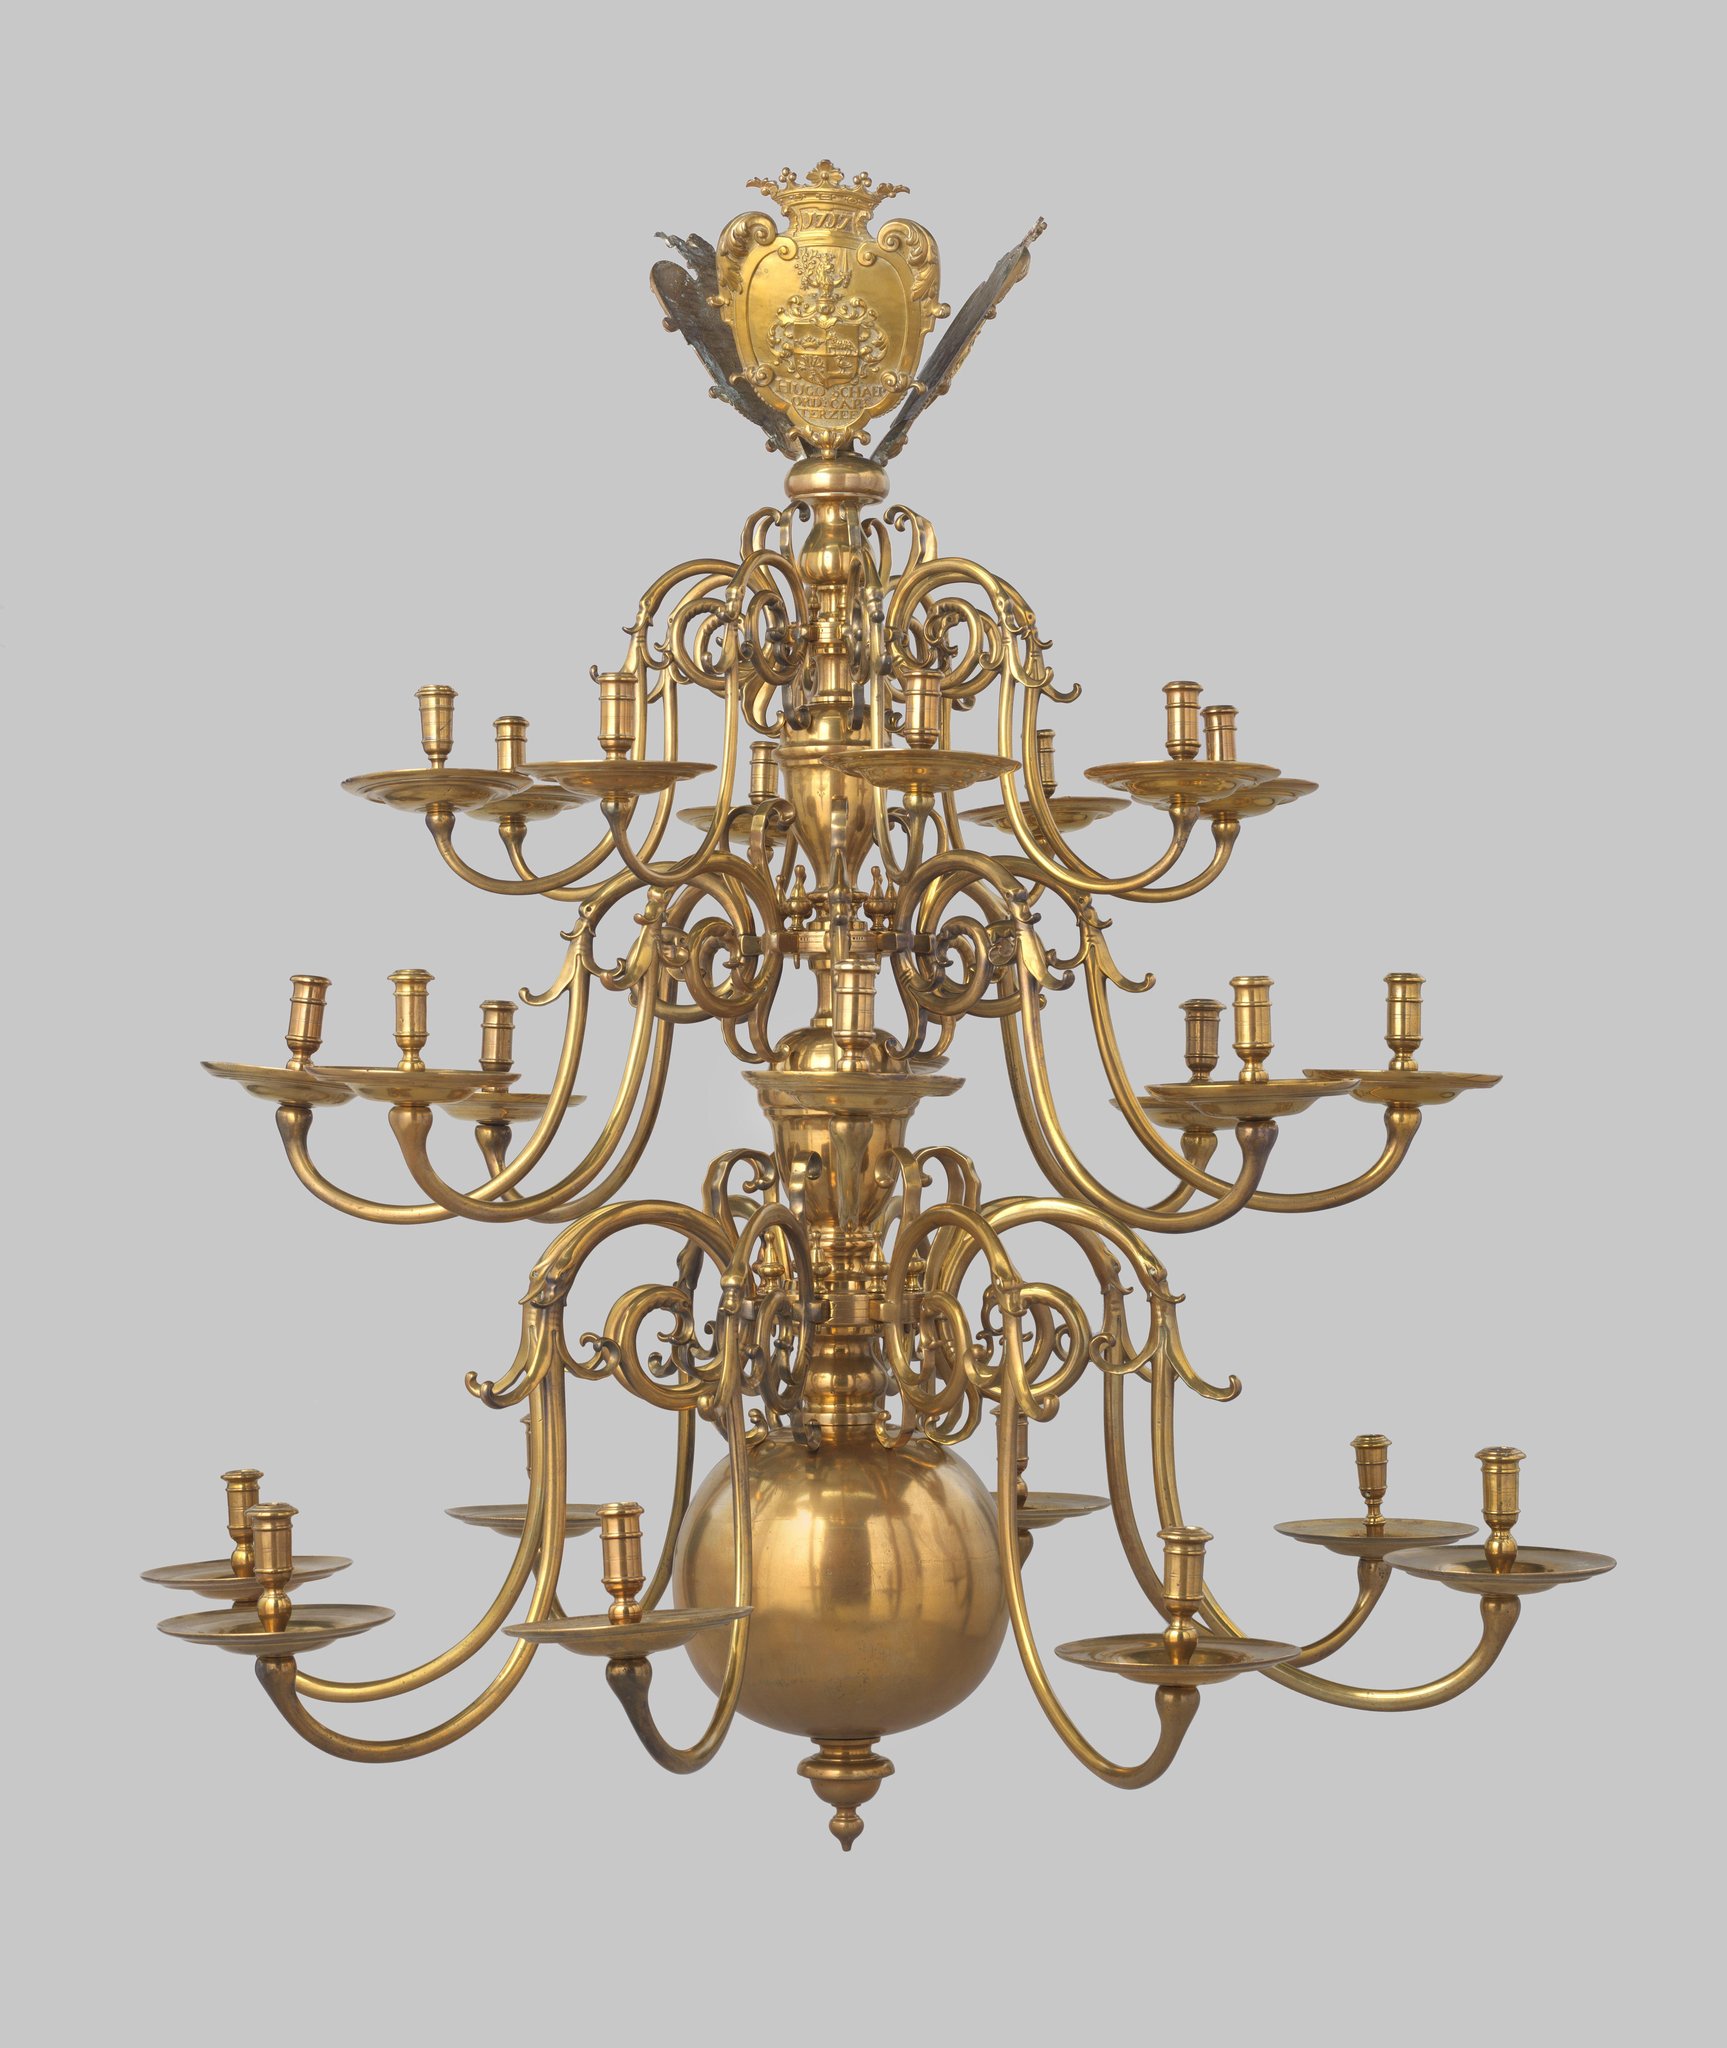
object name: chandelier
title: Arm van een kaarsenkroon in drie hoogten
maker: Anonymous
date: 1717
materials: brass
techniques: casting, screwed, turning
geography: amsterdam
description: De S-vormige arm is aan de stamzijde voorzien van een nok om deze met een pin in de standring te kunnen vastzetten. Bij de stam is de arm op het eind en naar het midden toe versierd met twee gestileerde dolfijnenkoppen en met krullen, waarvan de vorm aan het kwabornament is ontleend. Naar buiten toe eindigt de arm in een verdikking, waarin een van een schroefdraad voorzien gat is aangebracht ter bevestiging van de kaarsenhouder op de vetvanger. De arm is met behulp van hetzelfde model gegoten als de overige armen van de krans. De kaarsenhouder is cylindervormig met geprofileerd uitstekende rand en met een balustervoet, welke overgaat in een van een schroefdraad voorzien eind, waarin onderaan het centergat. De vetvanger is aan de bovenkant naar het midden toe twee keer verdiept. Aan de onderkant is deze rond het gat in het enigszins bolvormige midden geprofileerd en is de rand geribd. De vetvanger met behulp van hetzelfde model gegoten als de overige vetvangers van deze krans. De pin is voorzien van een vaasvormige knop. Dit is de achtste arm van de middelste standring, genummerd op de nok met het cijfer VIII.